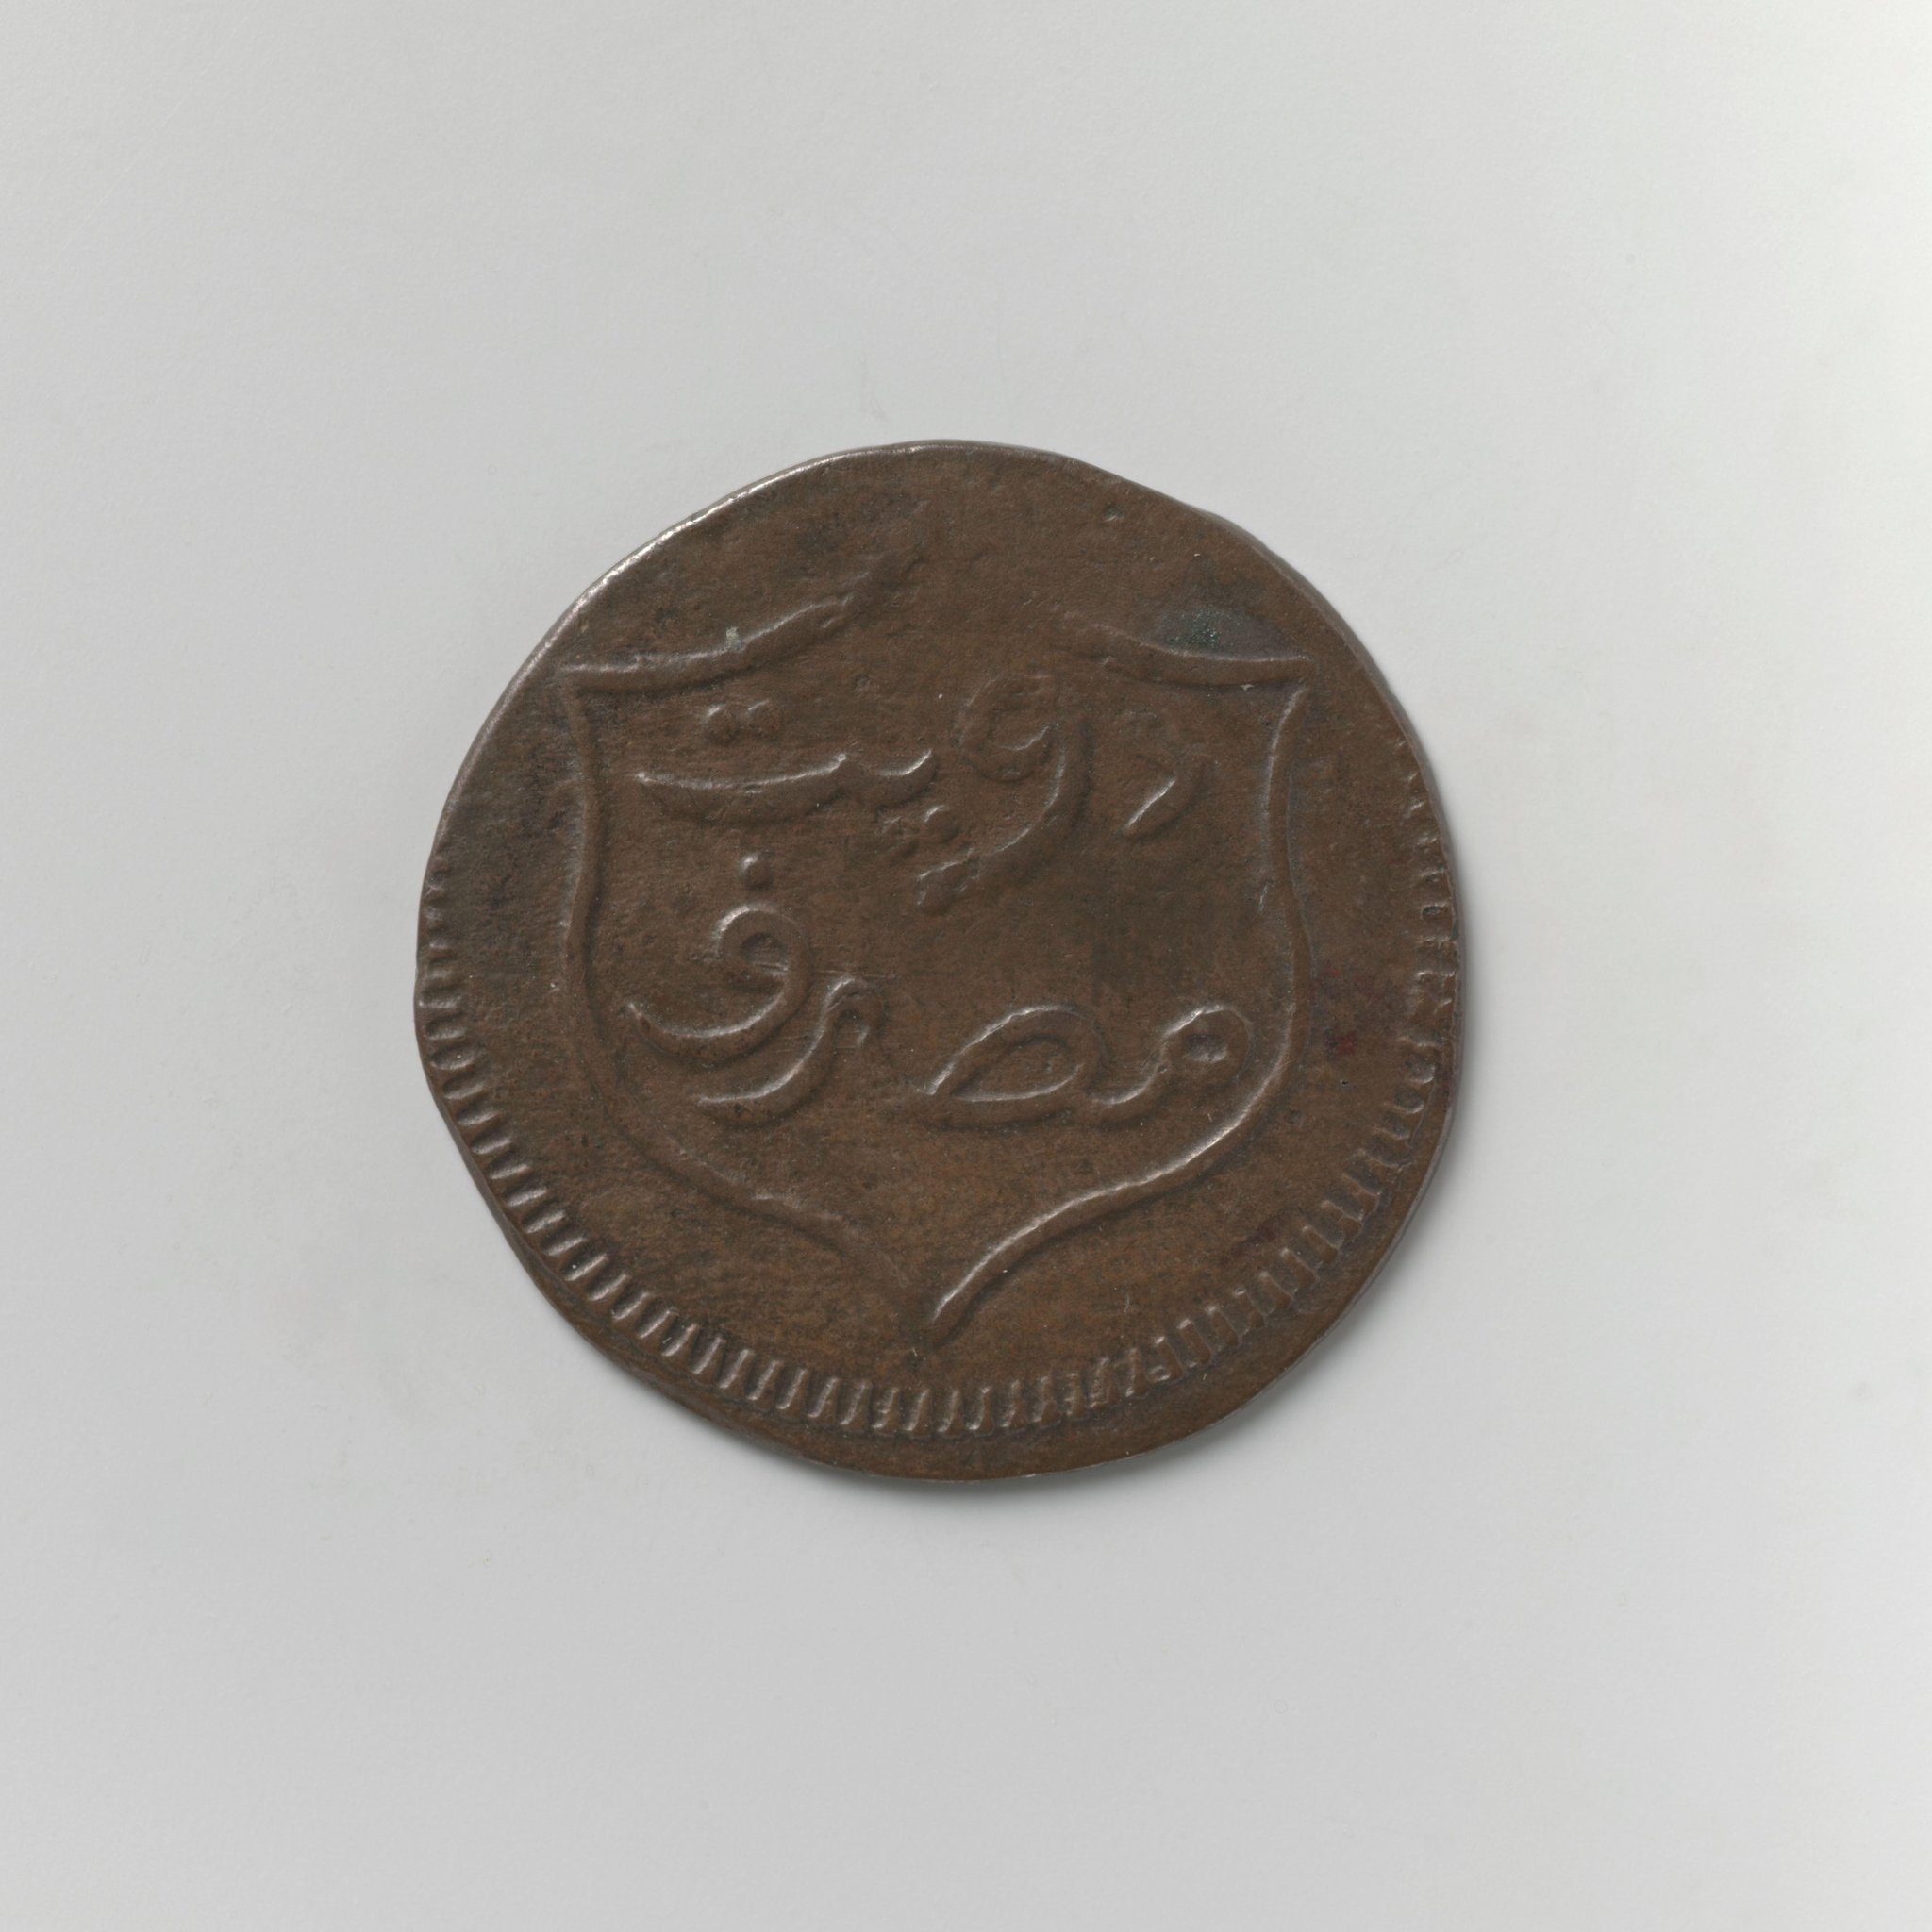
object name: coin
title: Duit voor Maloeka op Borneo onder Alexander Hare,1813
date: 1813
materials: copper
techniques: striking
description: Koperen munt. Voorzijde: in een wapenschild tweeregelig Maleis opschrift in Arabische lettertekens Keerzijde: in een wapenschild jaartal: 1813, waaronder jaartal 1228 in Islamitische tijdsrekening en in Arabische cijfers. Gladde rand.